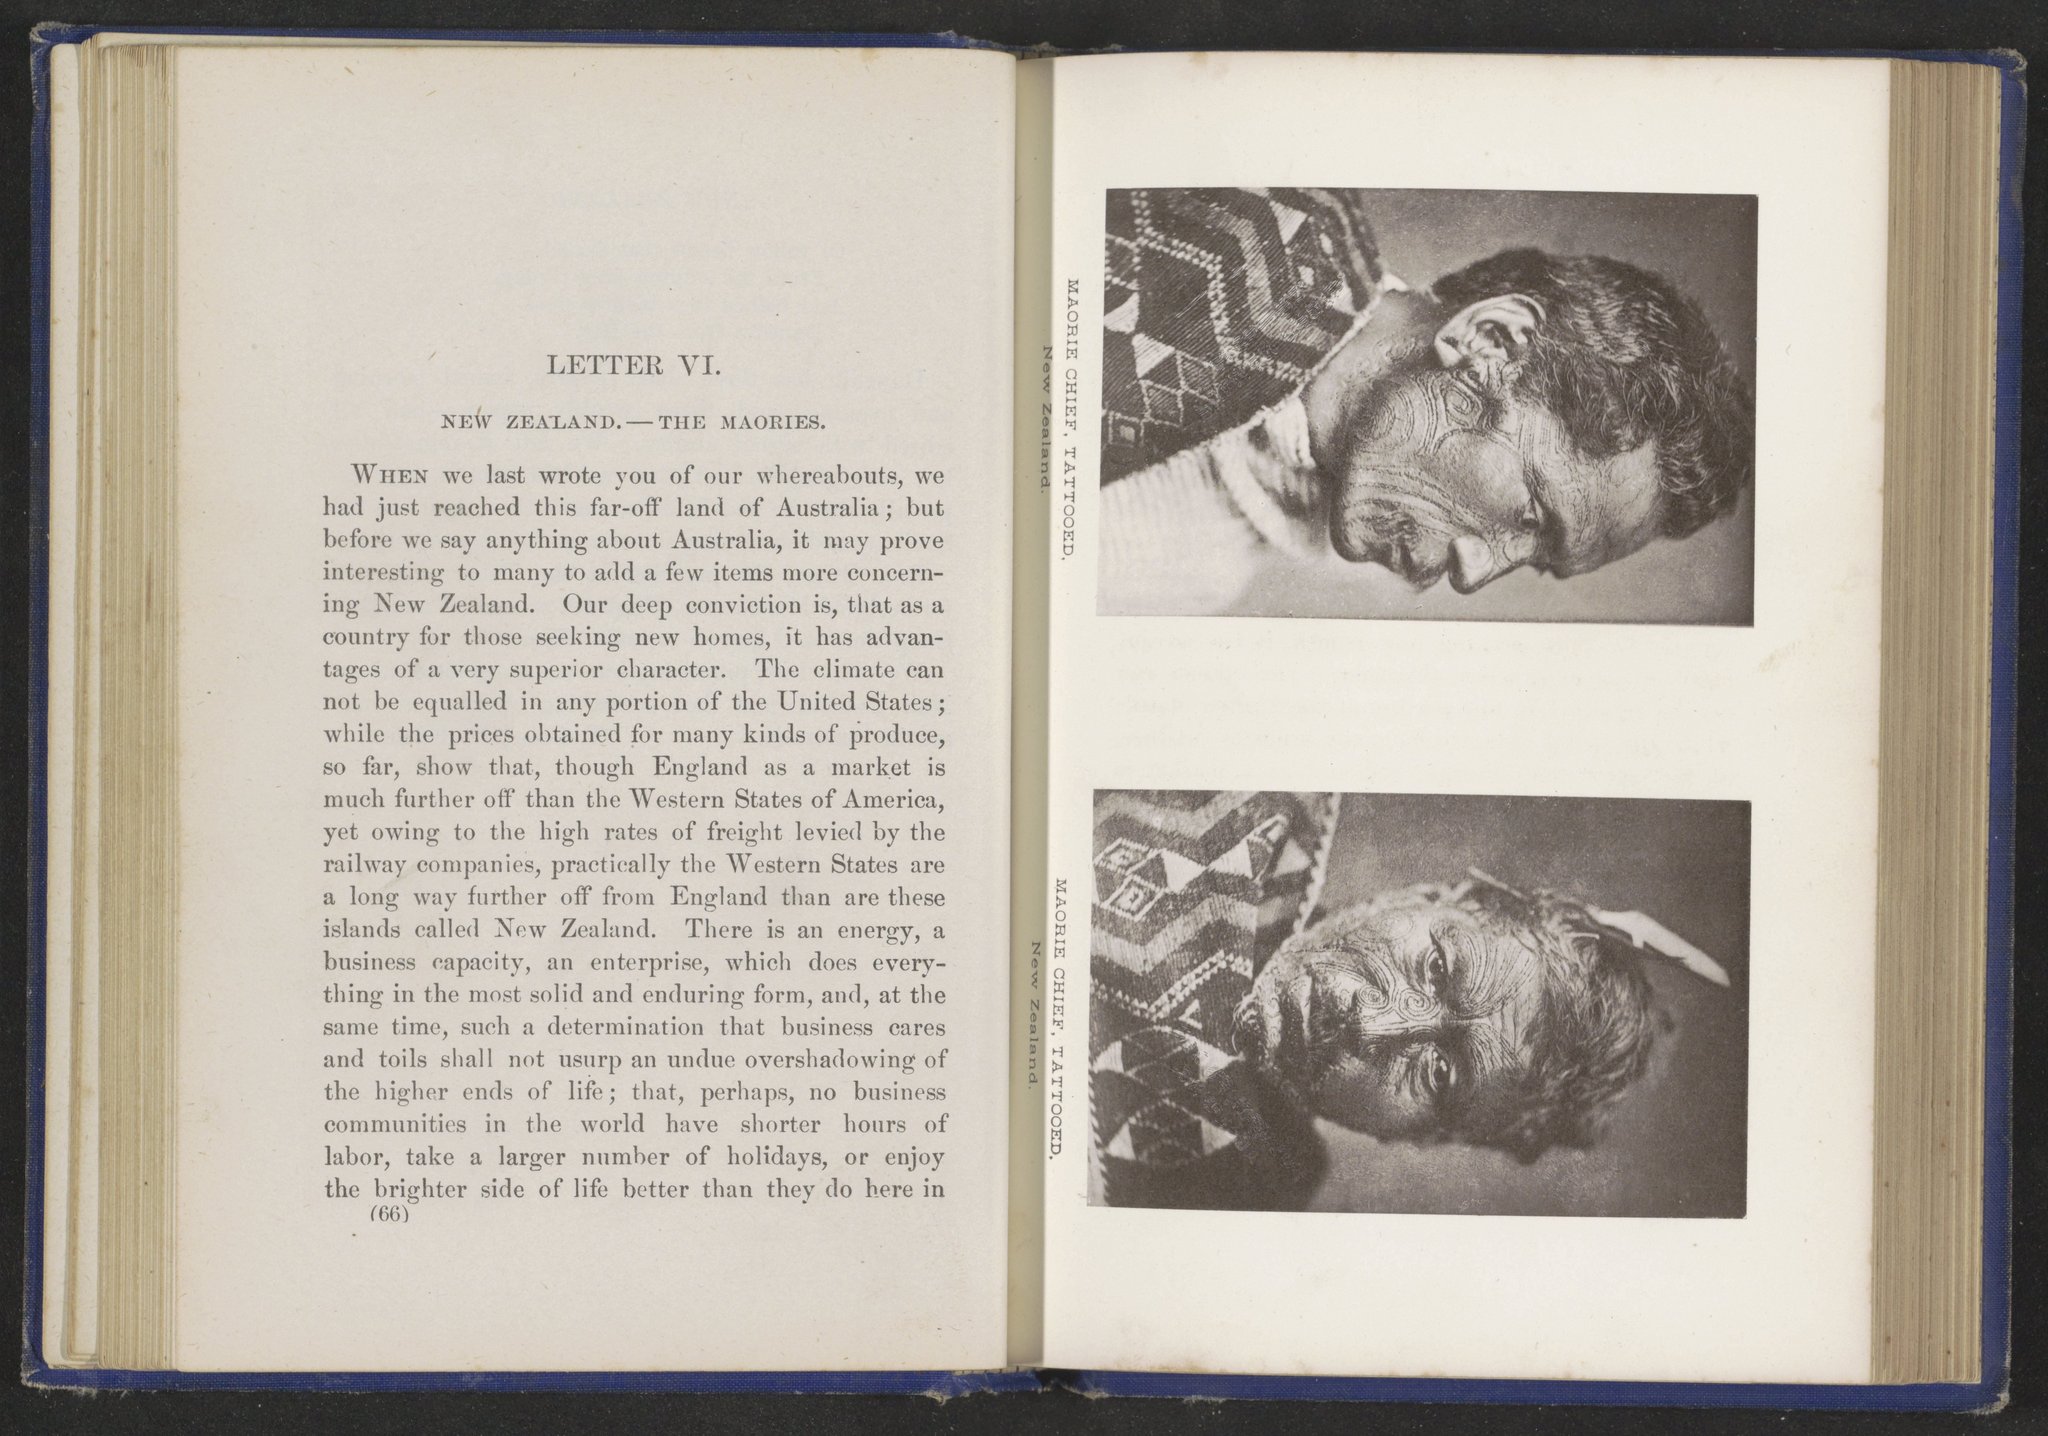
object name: page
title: Maorie chief, tattooed, New Zealand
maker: Anonymous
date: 1870-1882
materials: paper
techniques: photograph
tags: tattoo, adult man (+ front view), adult man (+ three-quarter view)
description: Links een zijaanzicht van een hoofdman, rechts een vooraanzicht.